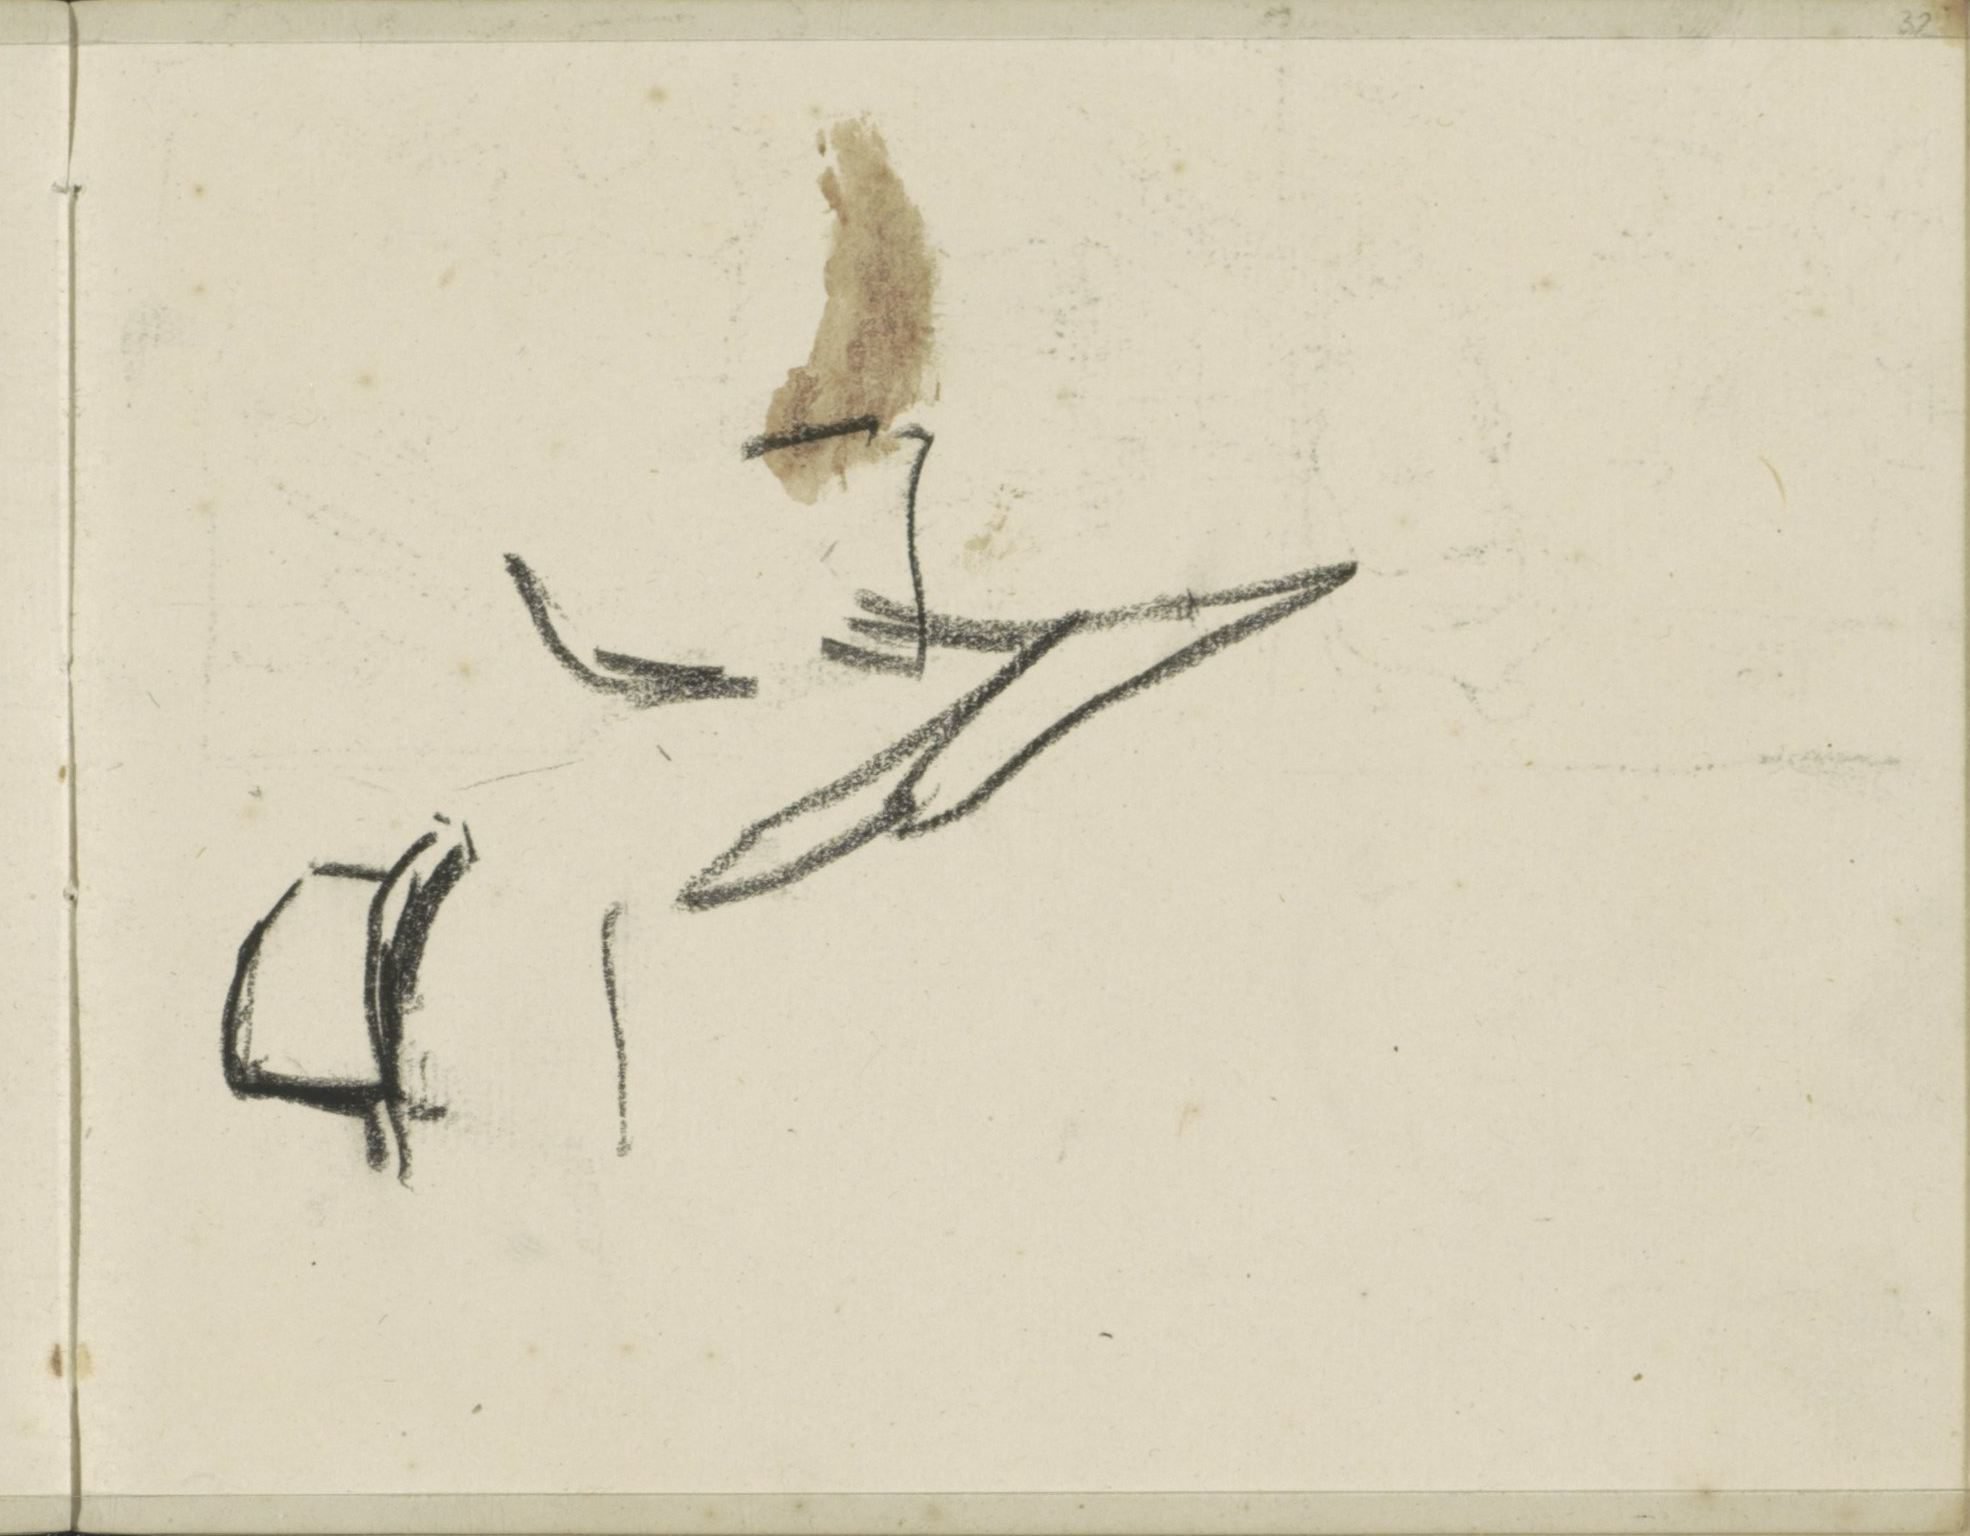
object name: sketchbook leaf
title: Man met hoed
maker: george hendrik breitner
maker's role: draughtsman, painter, print maker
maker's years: 1857-1923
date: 1886-1903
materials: chalk, paper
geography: amsterdam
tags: adult man, head-gear: hat (+ men's clothes)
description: Pagina 32 uit een schetsboek met 27 bladen.